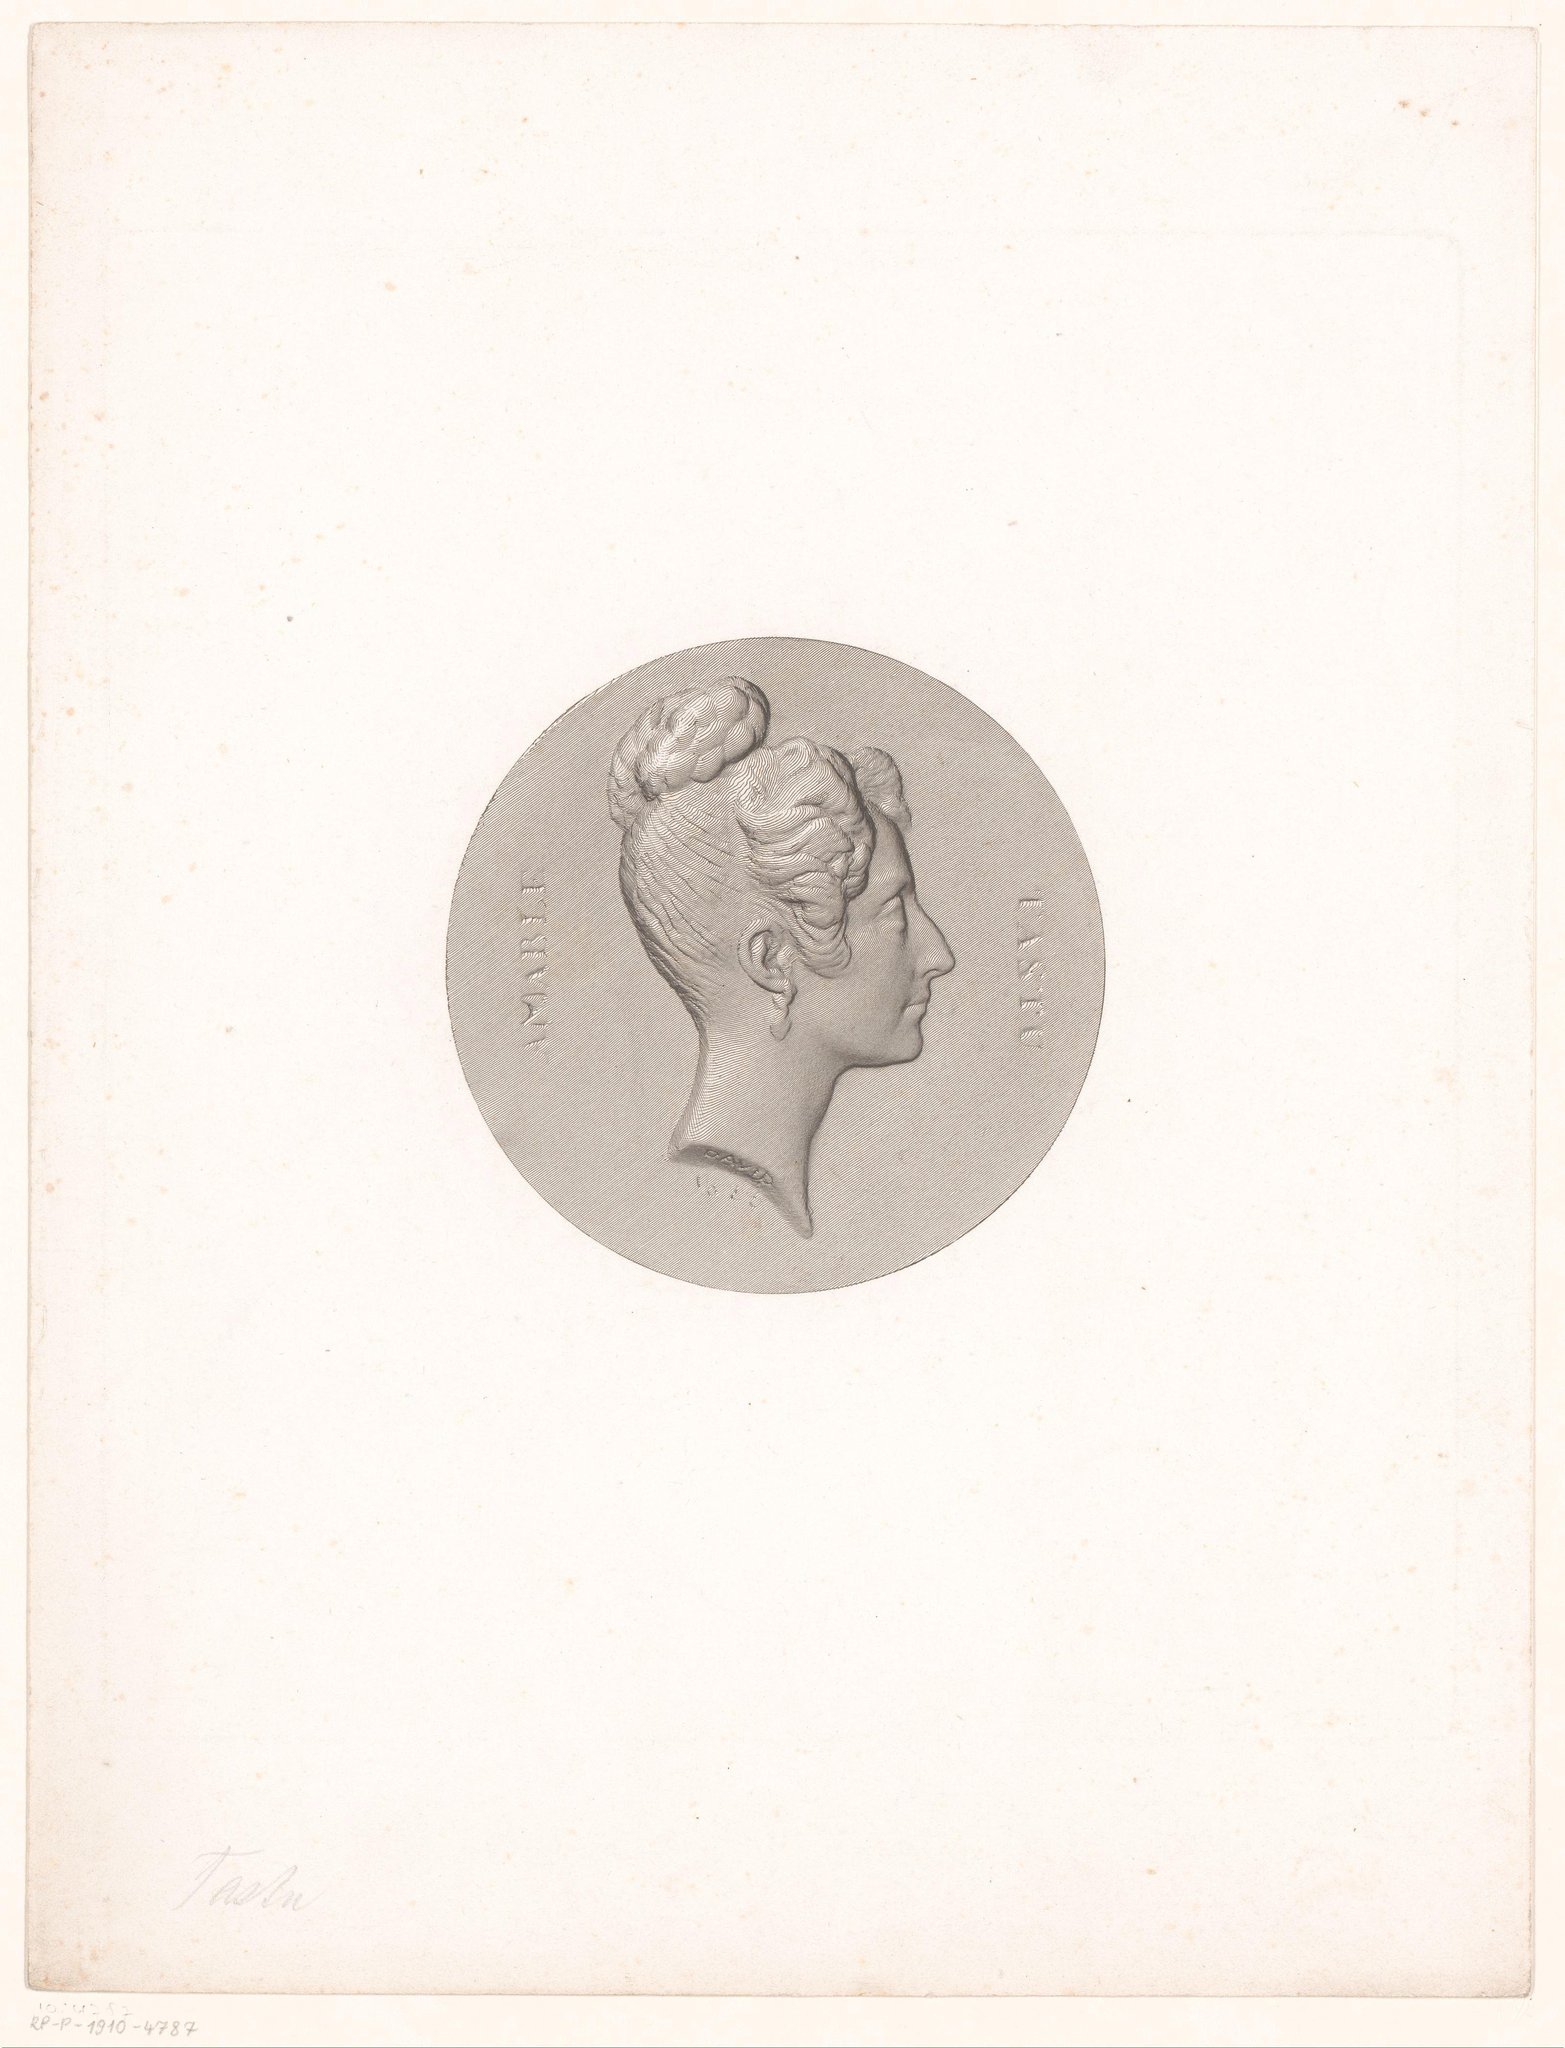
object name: print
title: Medaille met portret van Amable Tastu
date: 1815-1859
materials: paper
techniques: relief engraving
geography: france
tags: historical persons - bb - woman, ornament ~ medallion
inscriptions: collector's mark: Lugt 2228